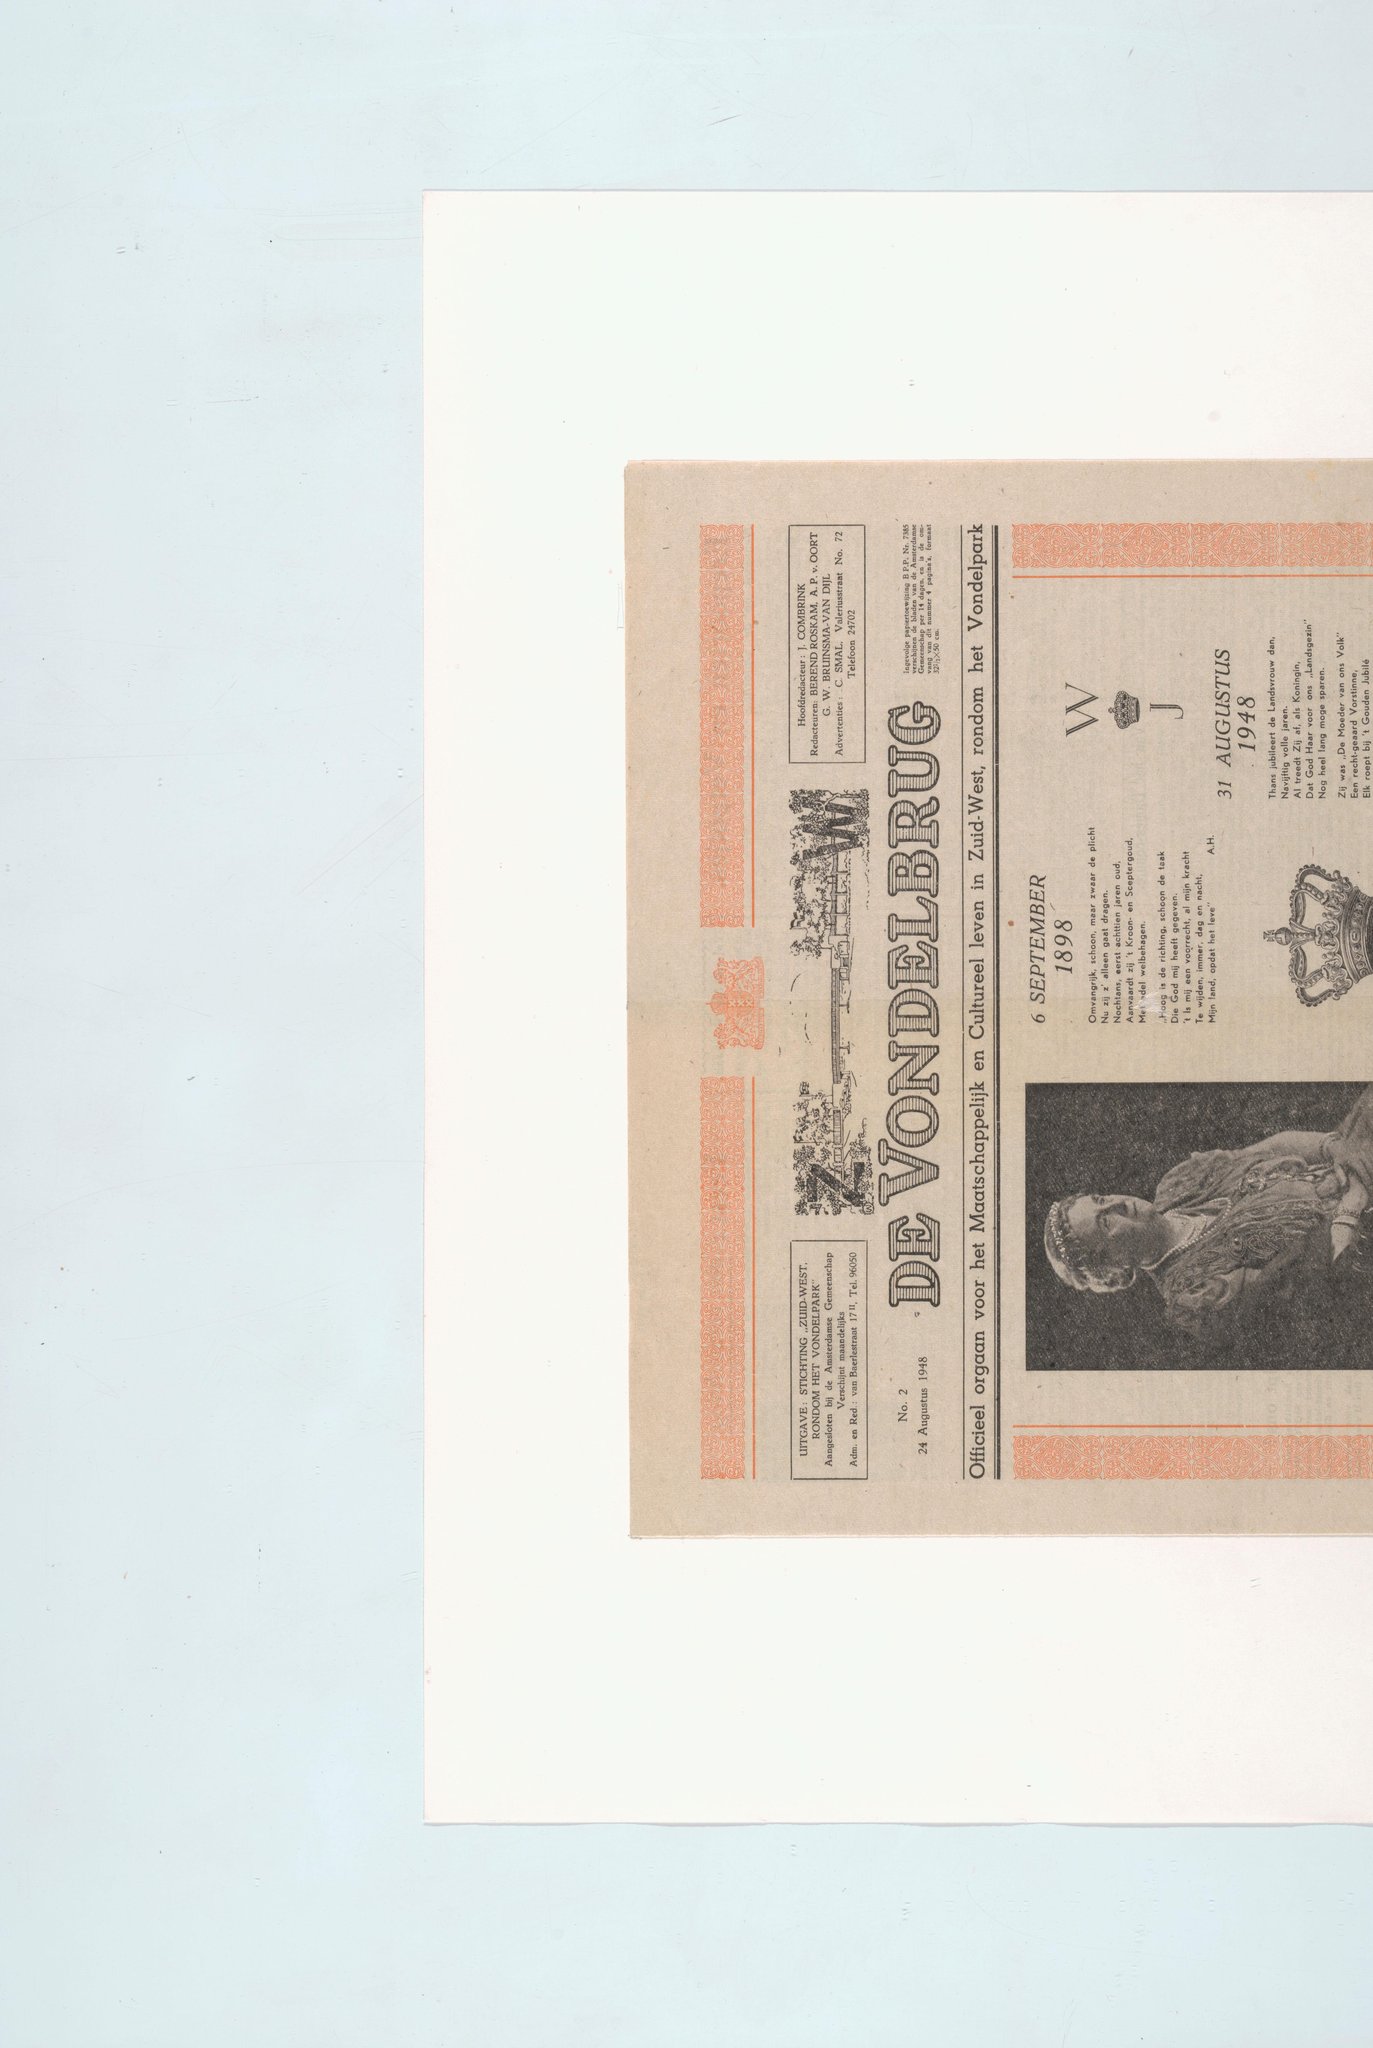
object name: text sheet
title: De Vondelbrug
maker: Anonymous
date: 1948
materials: paper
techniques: letterpress printing, offset printed, printing block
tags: the hague, print maker, wilhelmina of the netherlands, juliana of the netherlands, historical persons - bb - woman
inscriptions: collector's mark: Lugt 1641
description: Onderwerpsrubrieken binnen de Atlas Zeden en Gewoonten: Portretten, Portretten van Vorsten uit het huis van Oranje, Regeerende Vorsten, Koningen uit het huis van Oranje.